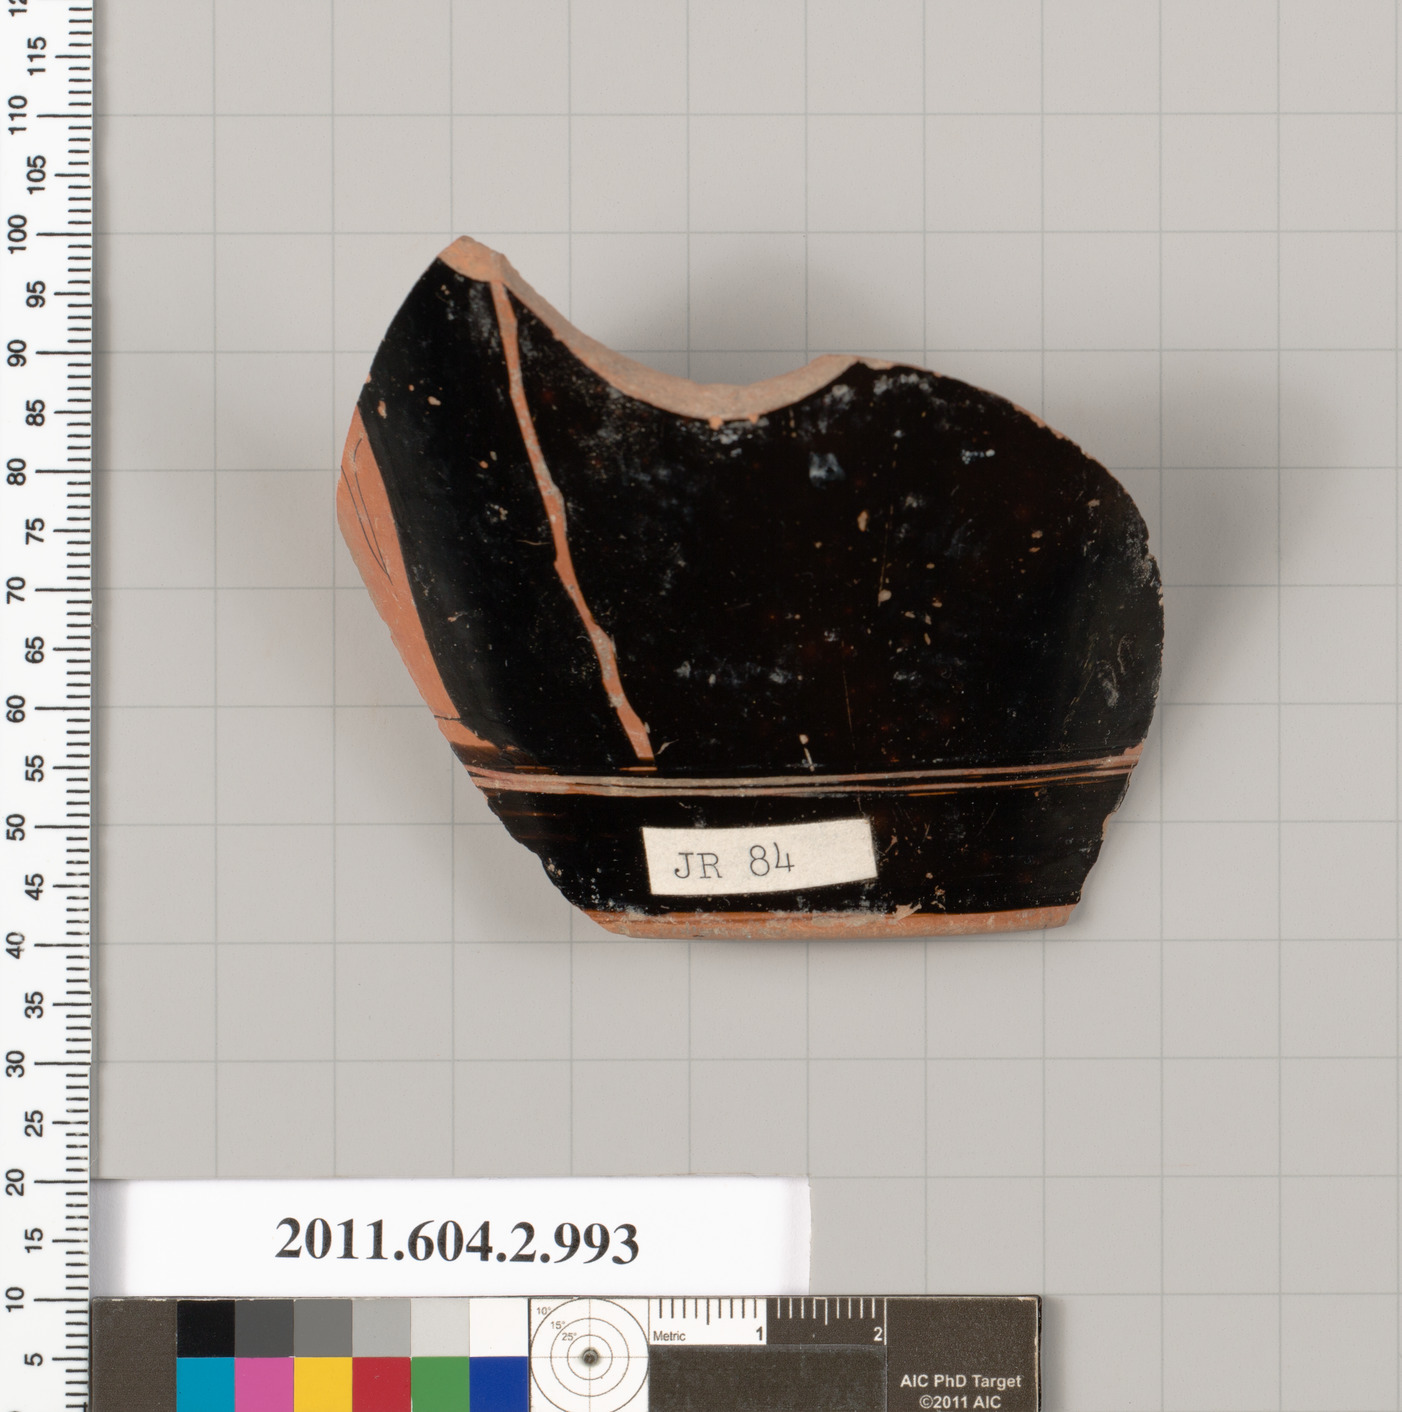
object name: olpe fragment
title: Terracotta fragment of an oinochoe: olpe (jug)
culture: greek, attic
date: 460-450 BCE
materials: terracotta